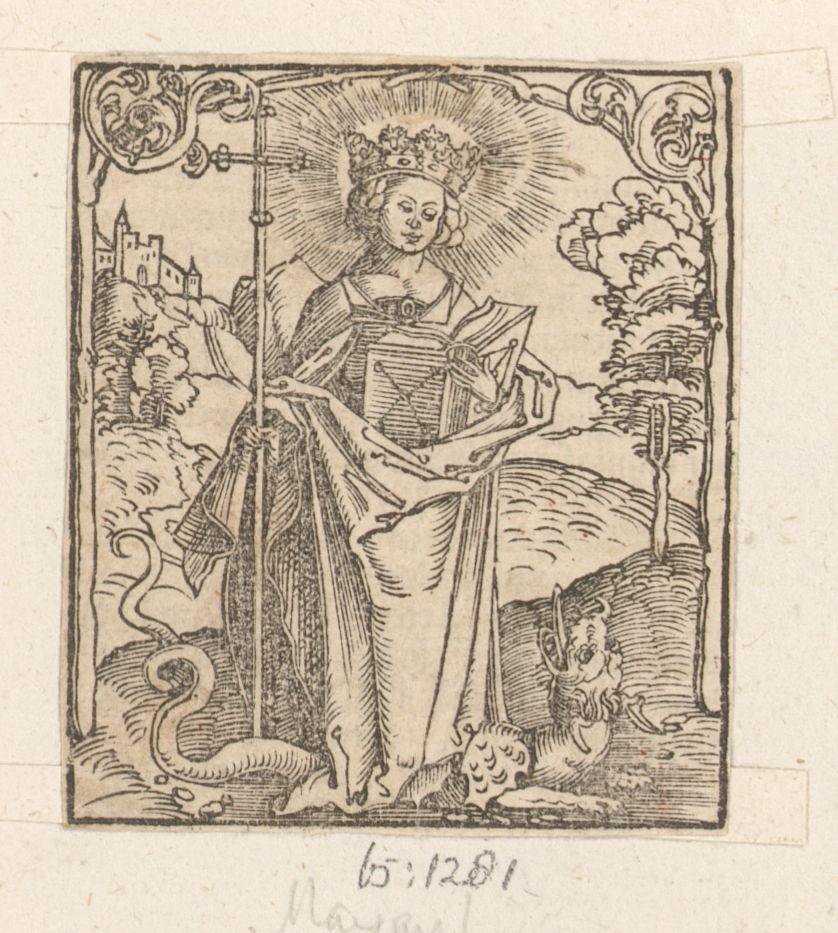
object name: print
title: H. Margaretha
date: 1515-1517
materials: paper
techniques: woodcut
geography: nuremberg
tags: the virgin martyr margaret of antioch; possible attributes: cross, crown, dragon (under feet or on chain), (chaplet of) pearls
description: De Heilige Margaretha met een staf en een boek, een draak onder de voeten vertrappend.. Prent maakt deel uit van een album.